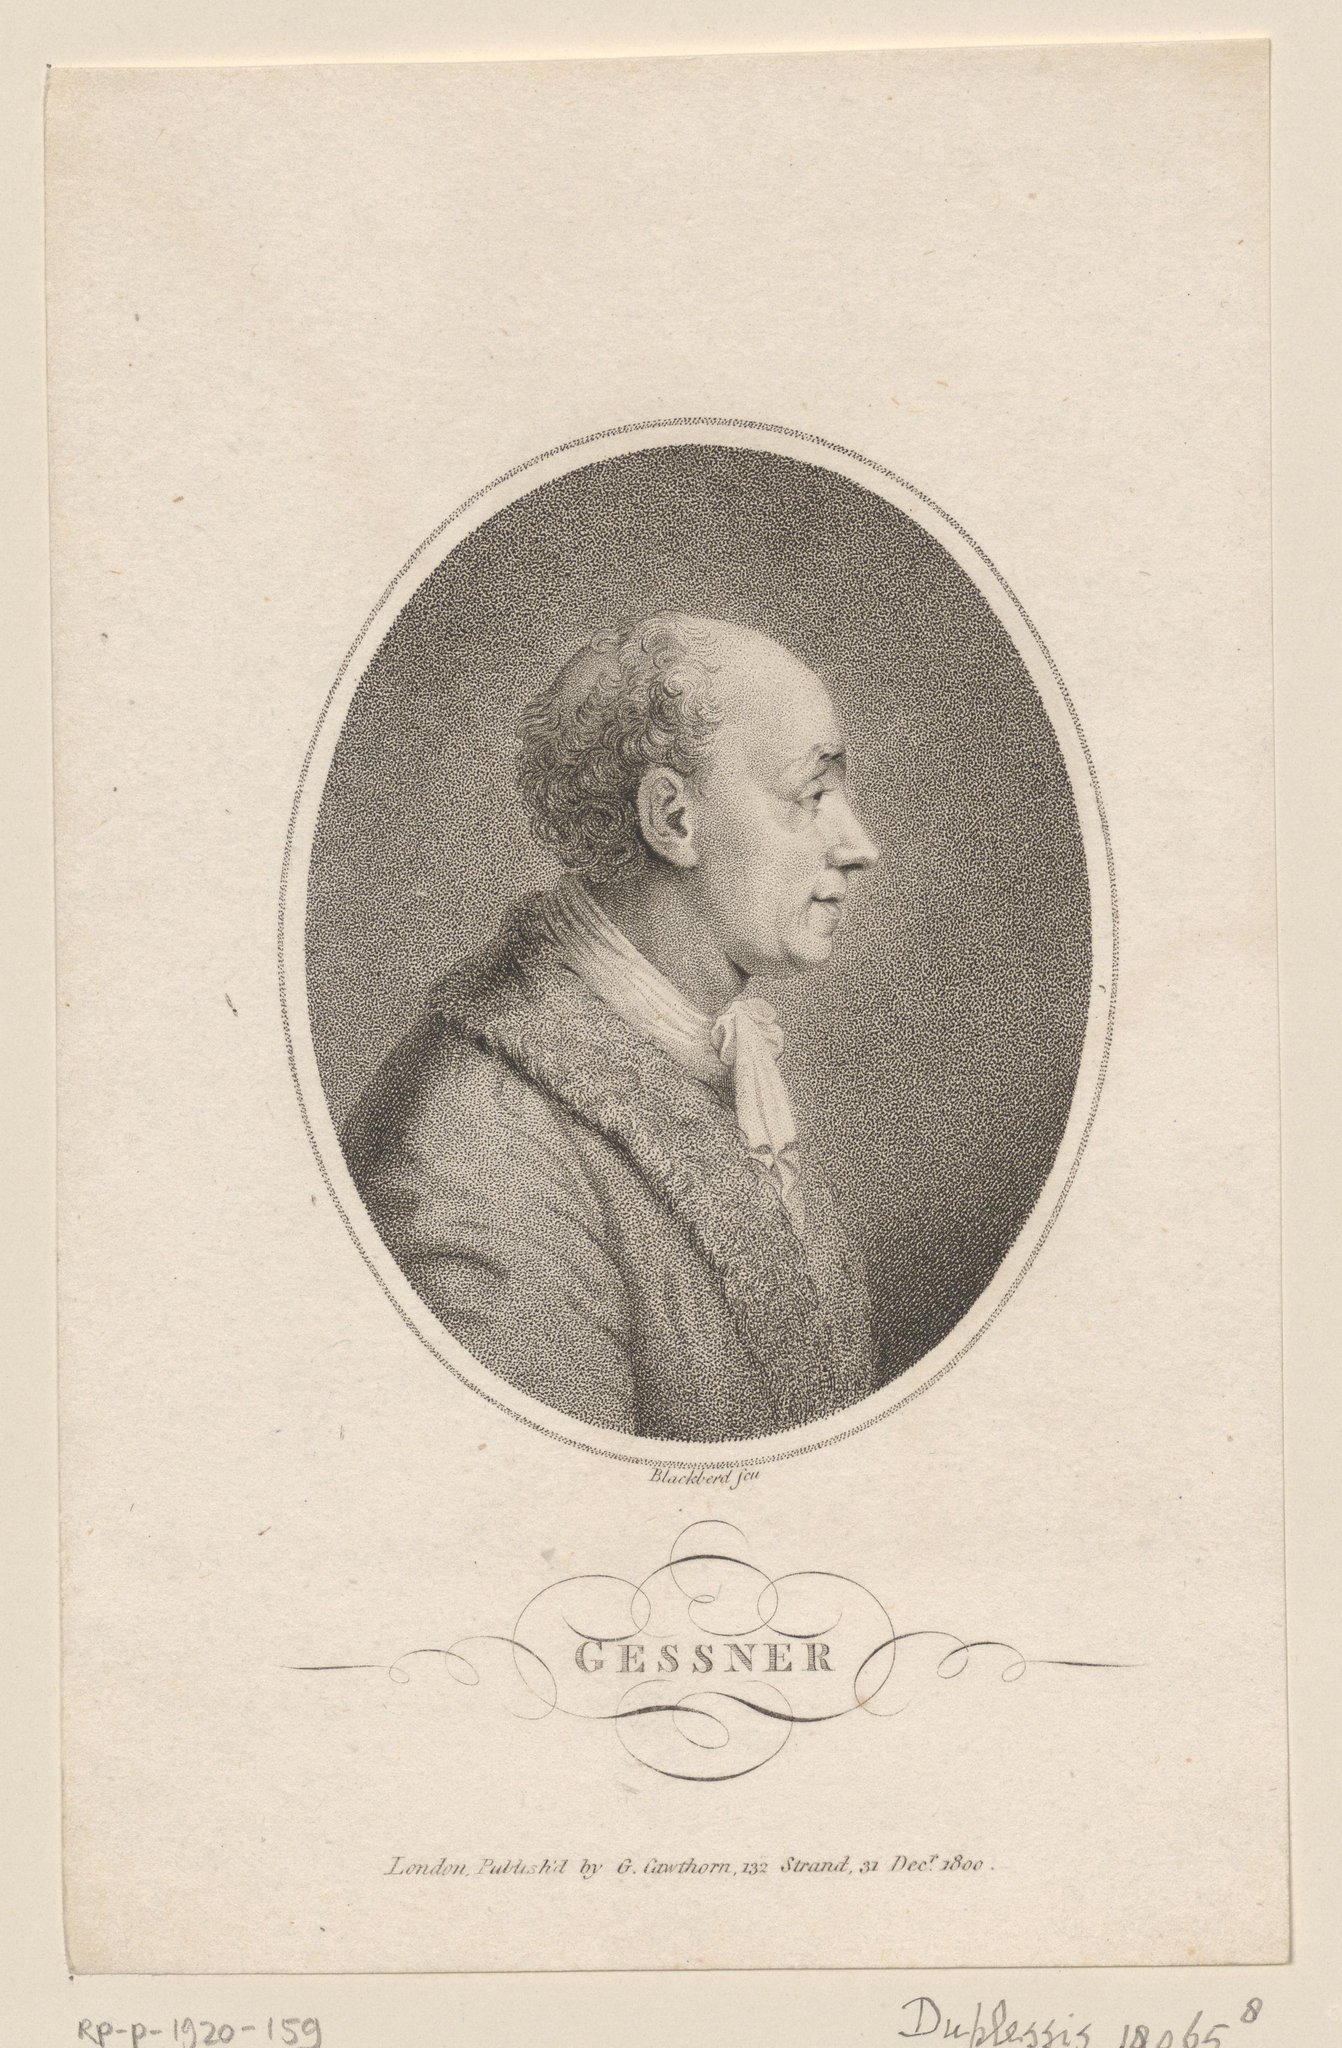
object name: print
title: Portret van Salomon Gessner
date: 1800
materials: paper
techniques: engraving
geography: london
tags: painter, print maker, salomon gessner, historical persons, portrait, self-portrait of painter, writer, poet, author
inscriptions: collector's mark: Lugt 2228